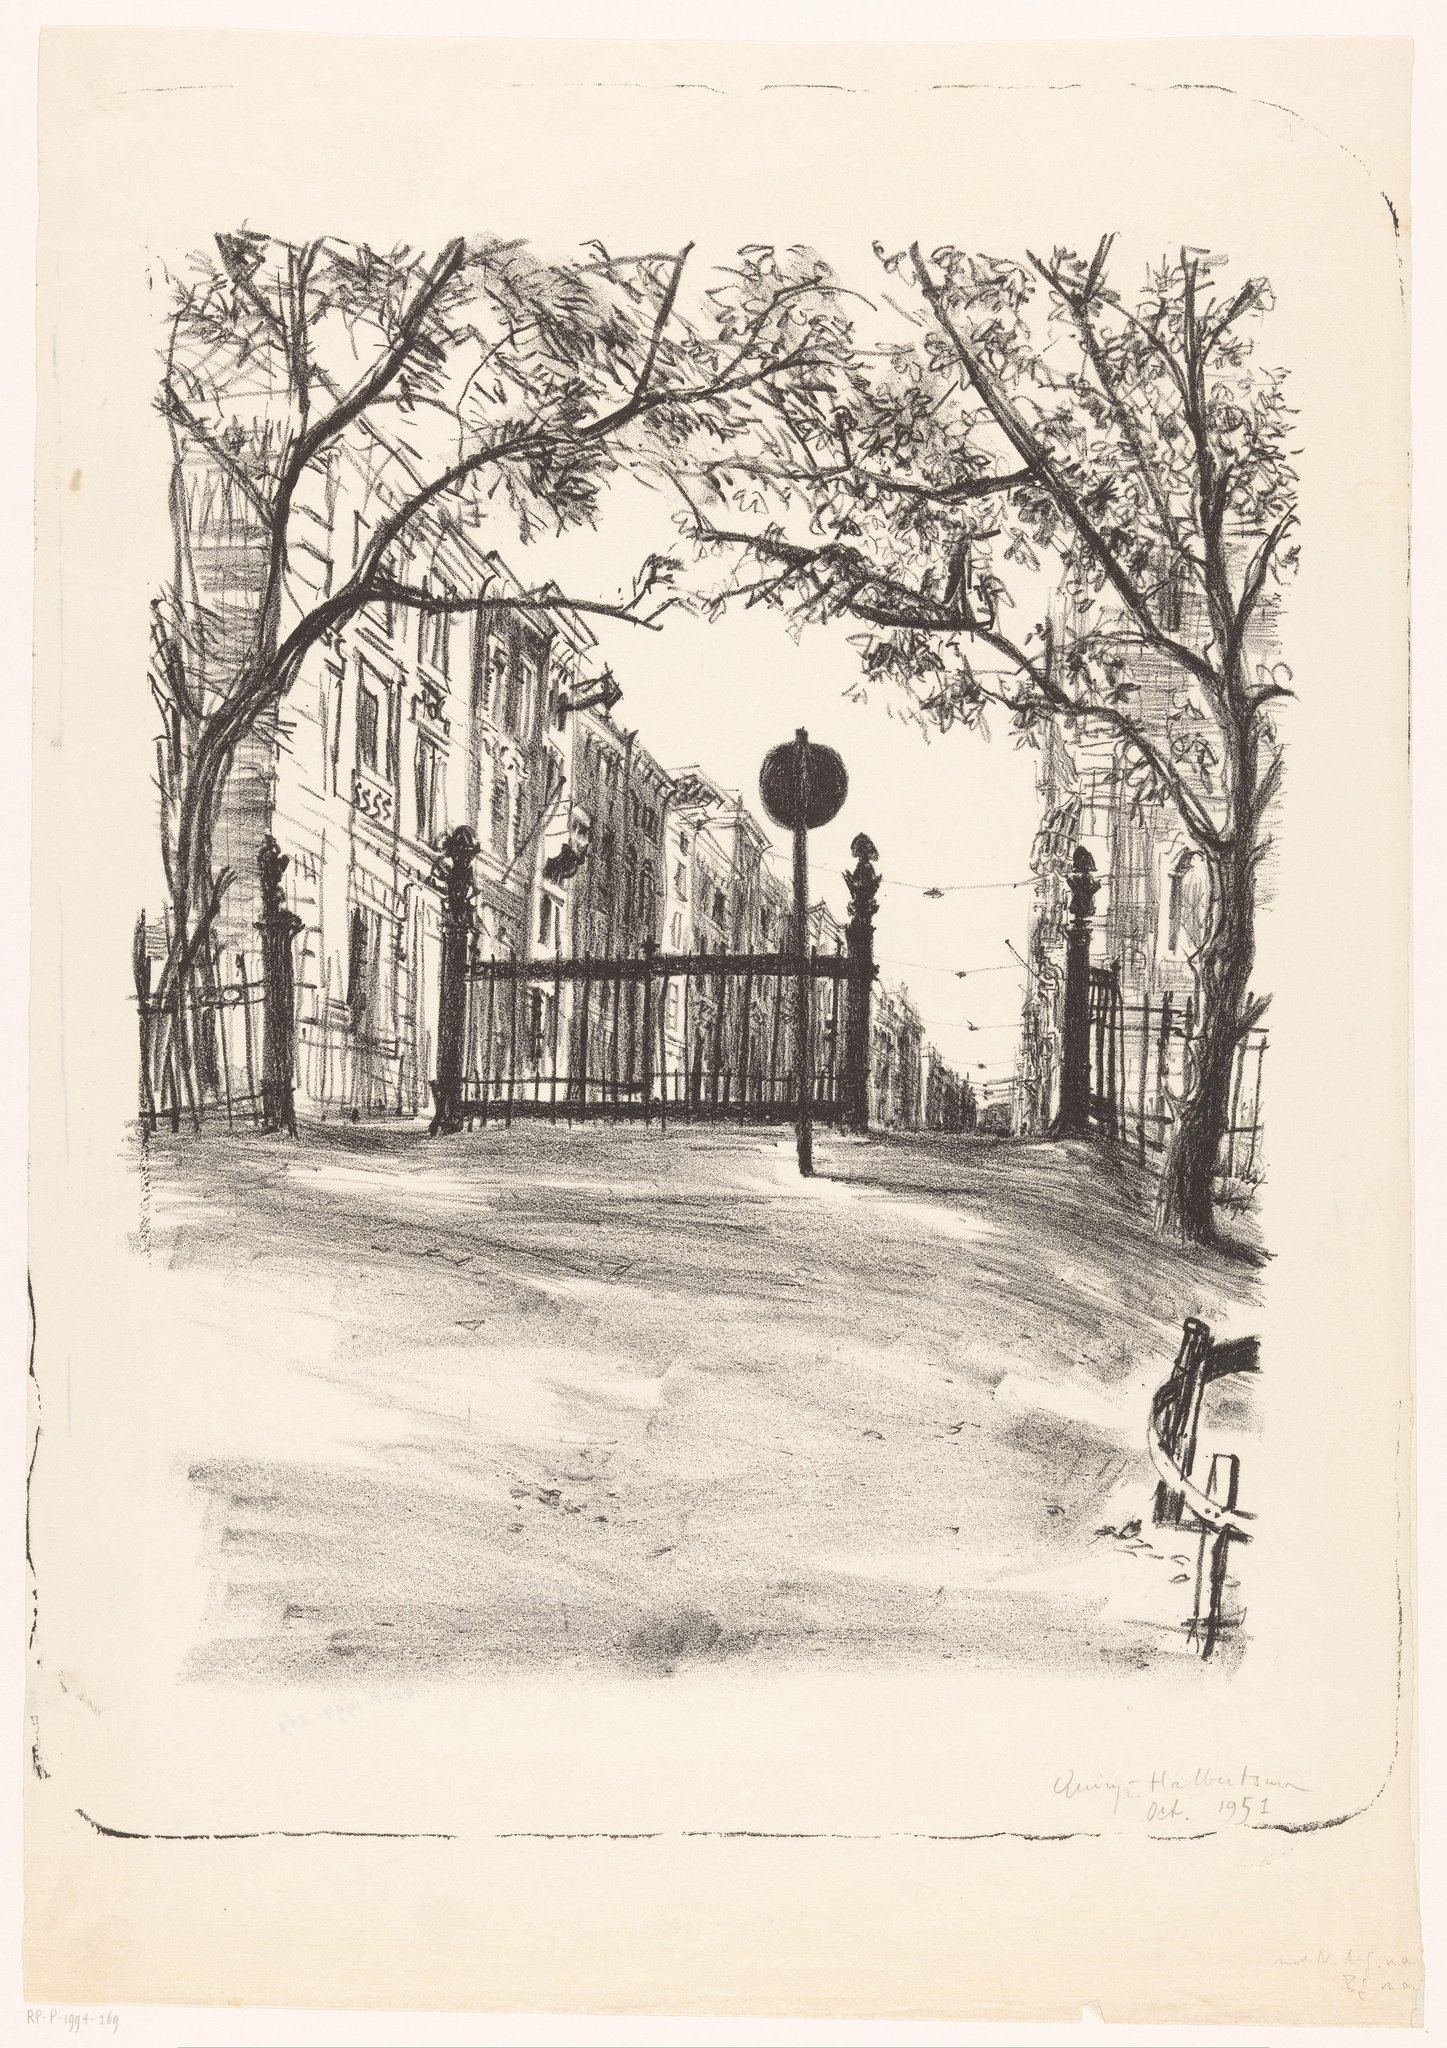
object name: print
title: Uitgang van het Vondelpark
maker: quirijn halbertsma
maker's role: draughtsman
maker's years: 1930-2014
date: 1910-1951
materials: paper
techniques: lithograph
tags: park, street lighting, street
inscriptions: collector's mark: Lugt 2228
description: Op de voorgrond een pad in het Amsterdamse Vondelpark met aan het einde daarvan een hek. Op de achtergrond een straat met hangende straatverlichting en aan weerszijden huizen, mogelijk de P.C. Hooftstraat.